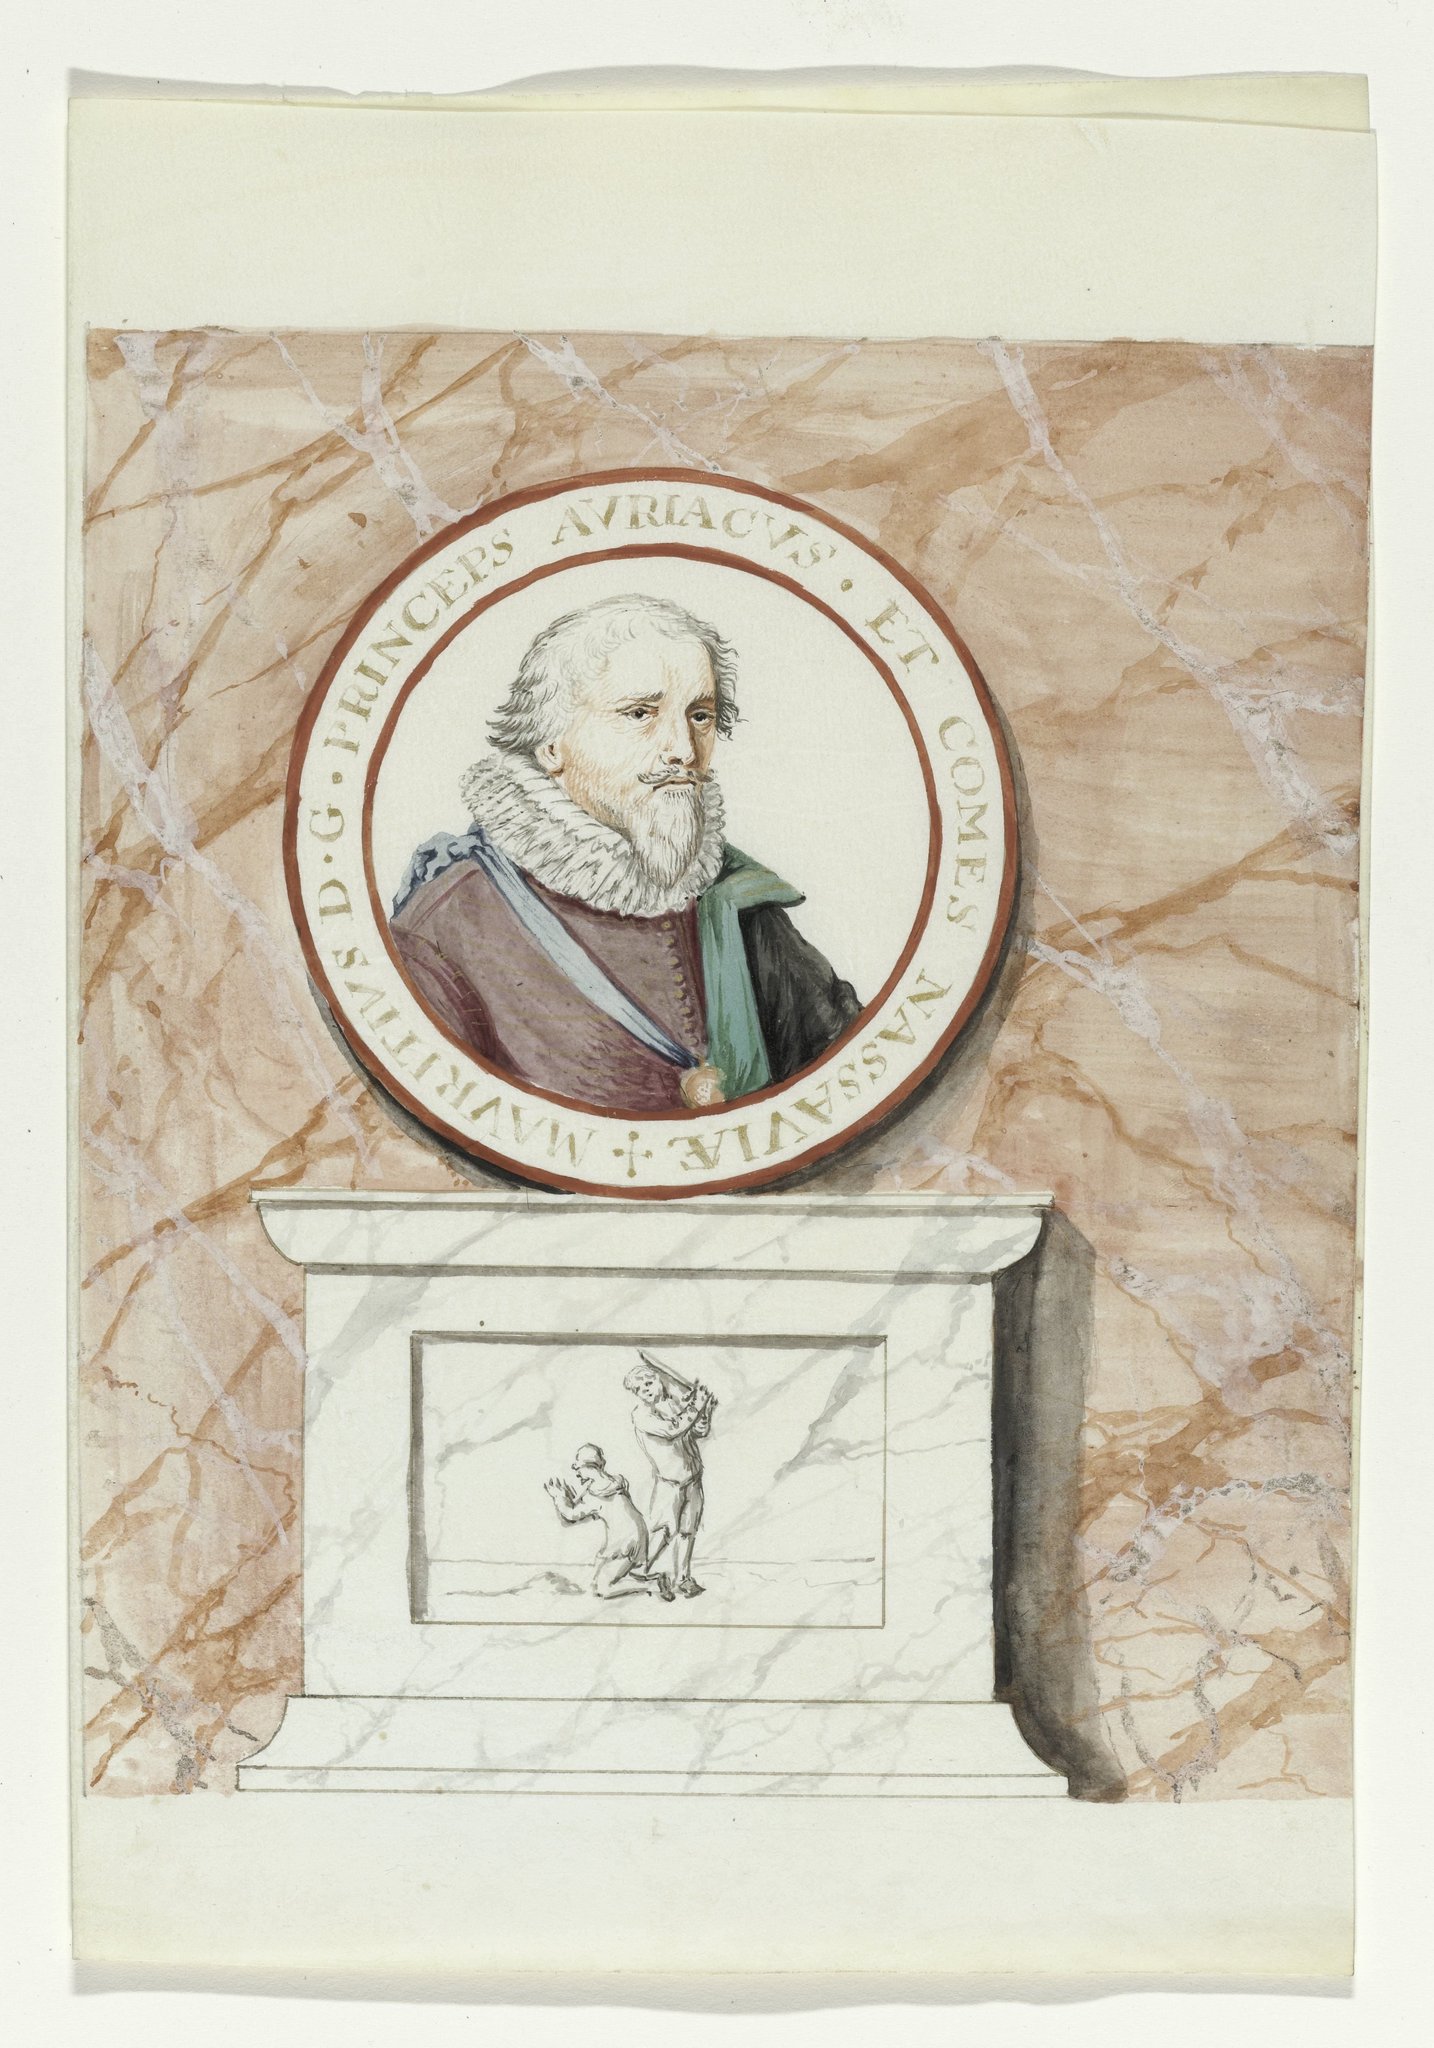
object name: drawing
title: Regtspleging van Oldenbarnevelt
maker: Anonymous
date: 1710-1720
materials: ink, parchment, watercolor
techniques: pen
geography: netherlands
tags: johan van oldenbarnevelt, the hague, maurice (prince of orange)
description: Aquarel met het portret van prins Maurits binnen randschrift 'MAVRITIVS D.G.PRINCEPS AVRIACVS.ET COMES NASSAVIÆ' op gemarmerd altaar waarop afbeelding van een terechtstelling. Behorende bij serie aquarellen in boek. Zie ook het bijbehorende spotdicht.